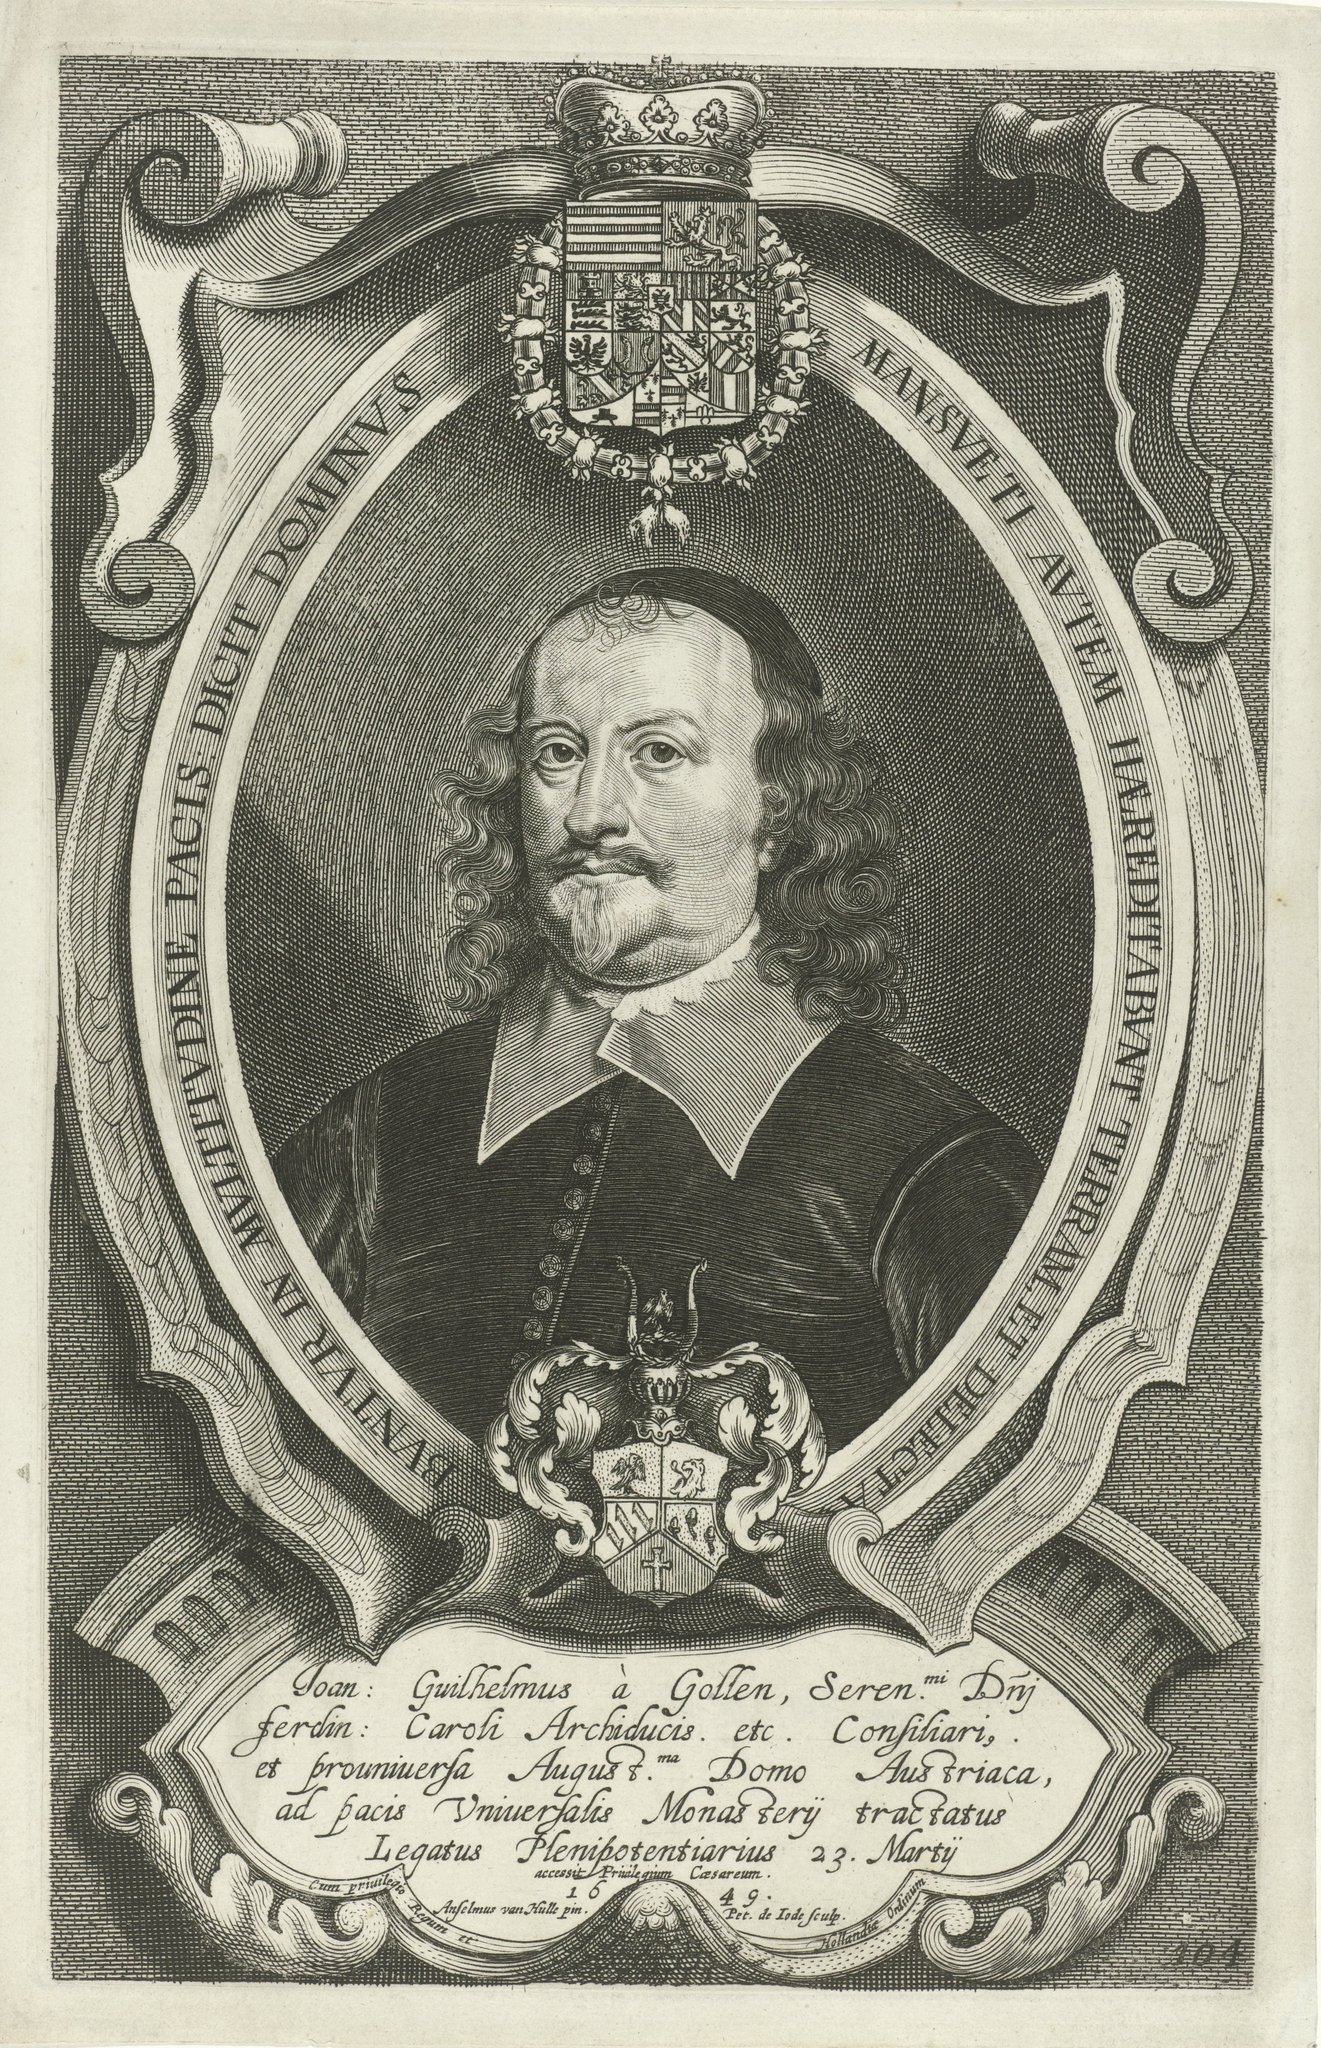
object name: print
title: Hommes illustres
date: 1649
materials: paper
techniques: engraving, etching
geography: antwerp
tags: knighthood order of the golden fleece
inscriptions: collector's mark: Lugt 2228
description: Busteportret van Johannes Wilhelm von Gollen, met kalot. Rechtsonder: 104. Het portret is gevat in een cartouche met het wapenschild van de geportretteerde, een keten met de Orde van het Gulden Vlies en een randschrift in het Latijn. In de cartouche onder de omlijsting een vijfregelig onderschrift in het Latijn. Prent uit een serie portretten naar schilderijen van Anselmus van Hulle van alle gedelegeerden bij de vredesonderhandelingen te Münster en Osnabrück.